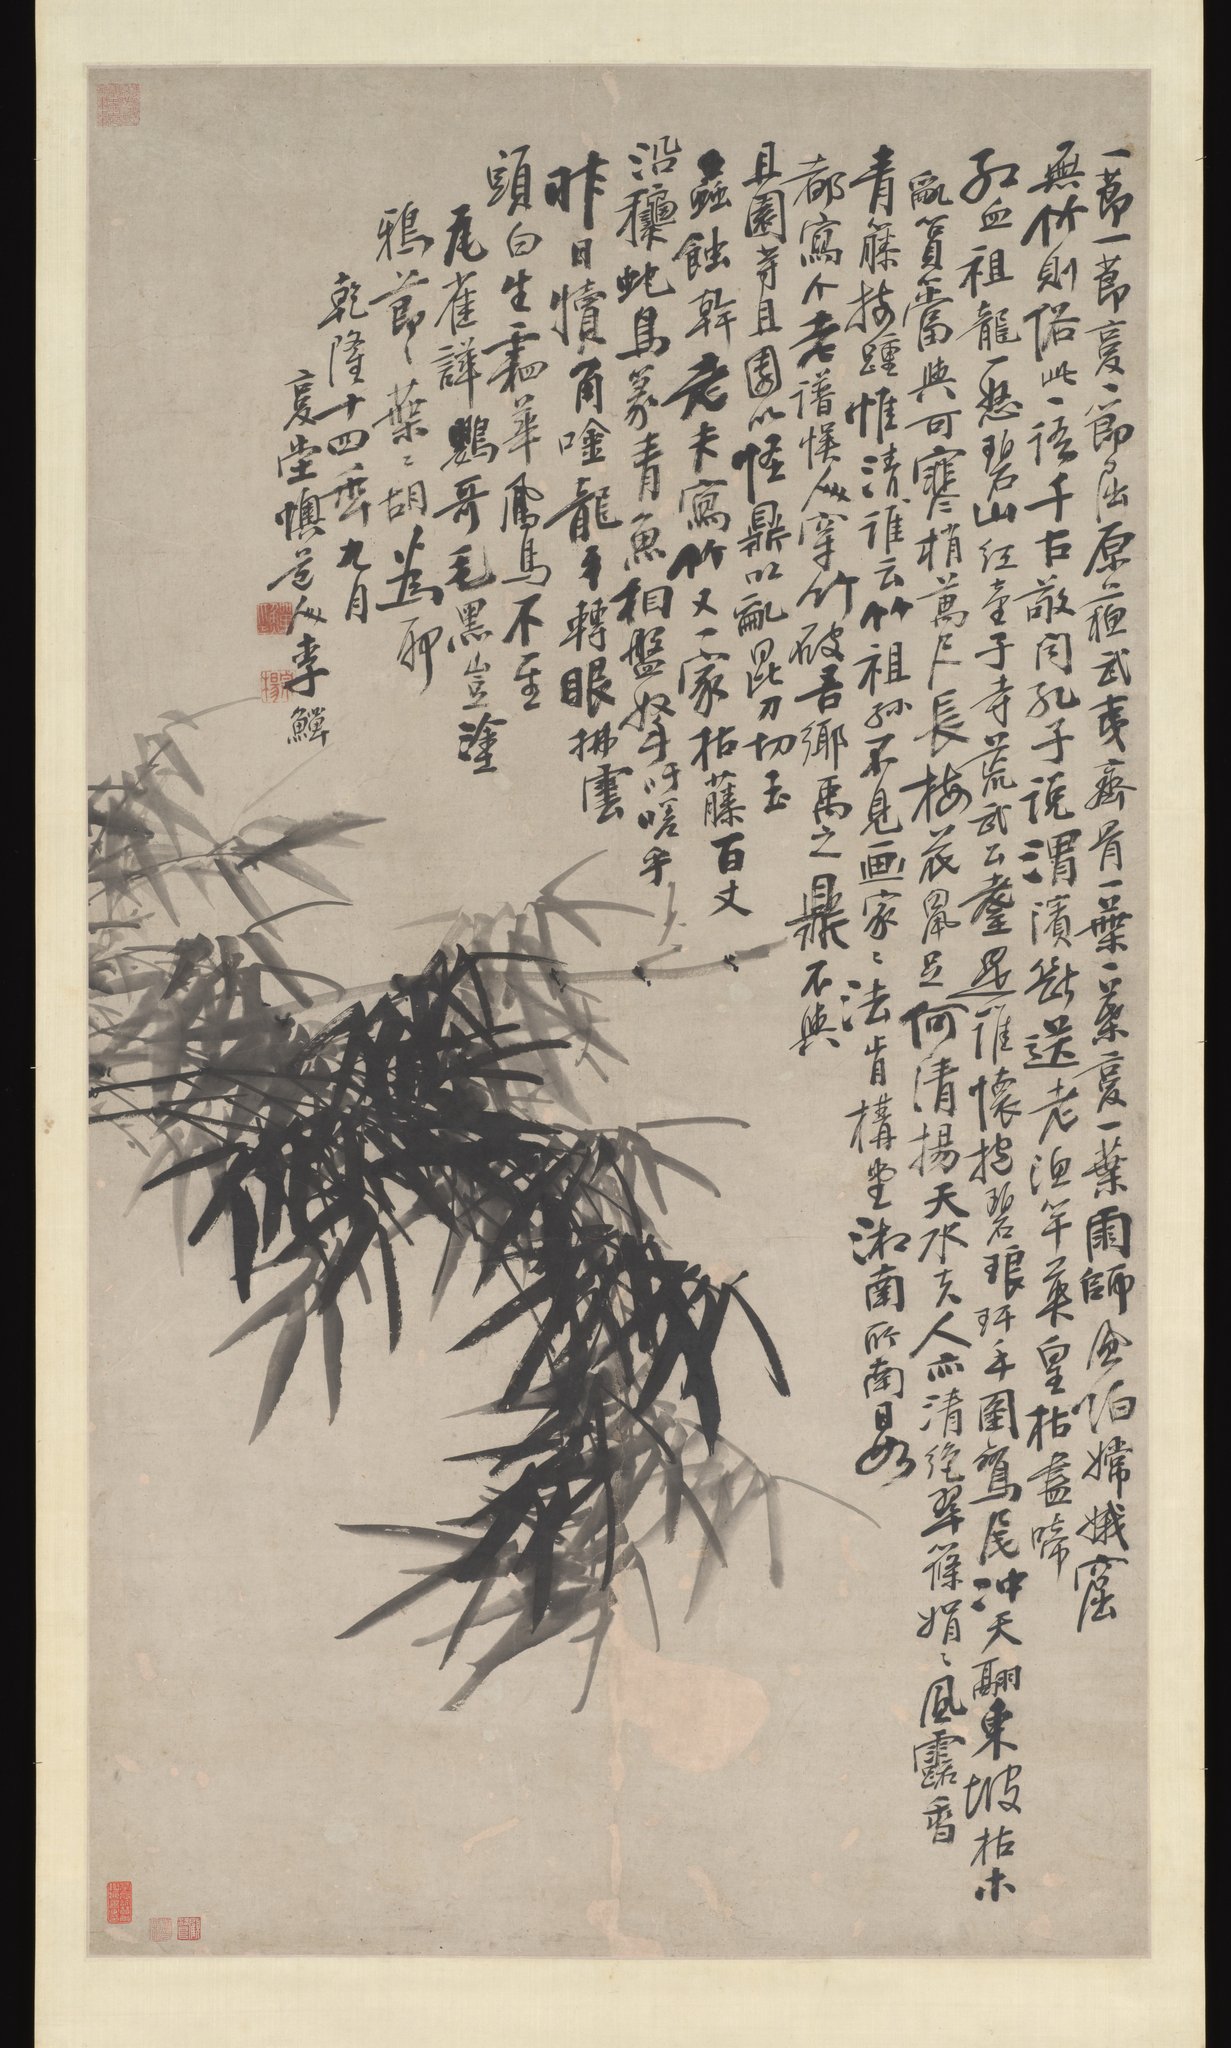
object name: hanging scroll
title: Ink bamboo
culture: chinese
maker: li shan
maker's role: artist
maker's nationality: chinese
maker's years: 1686-1756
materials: ink, paper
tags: bamboo